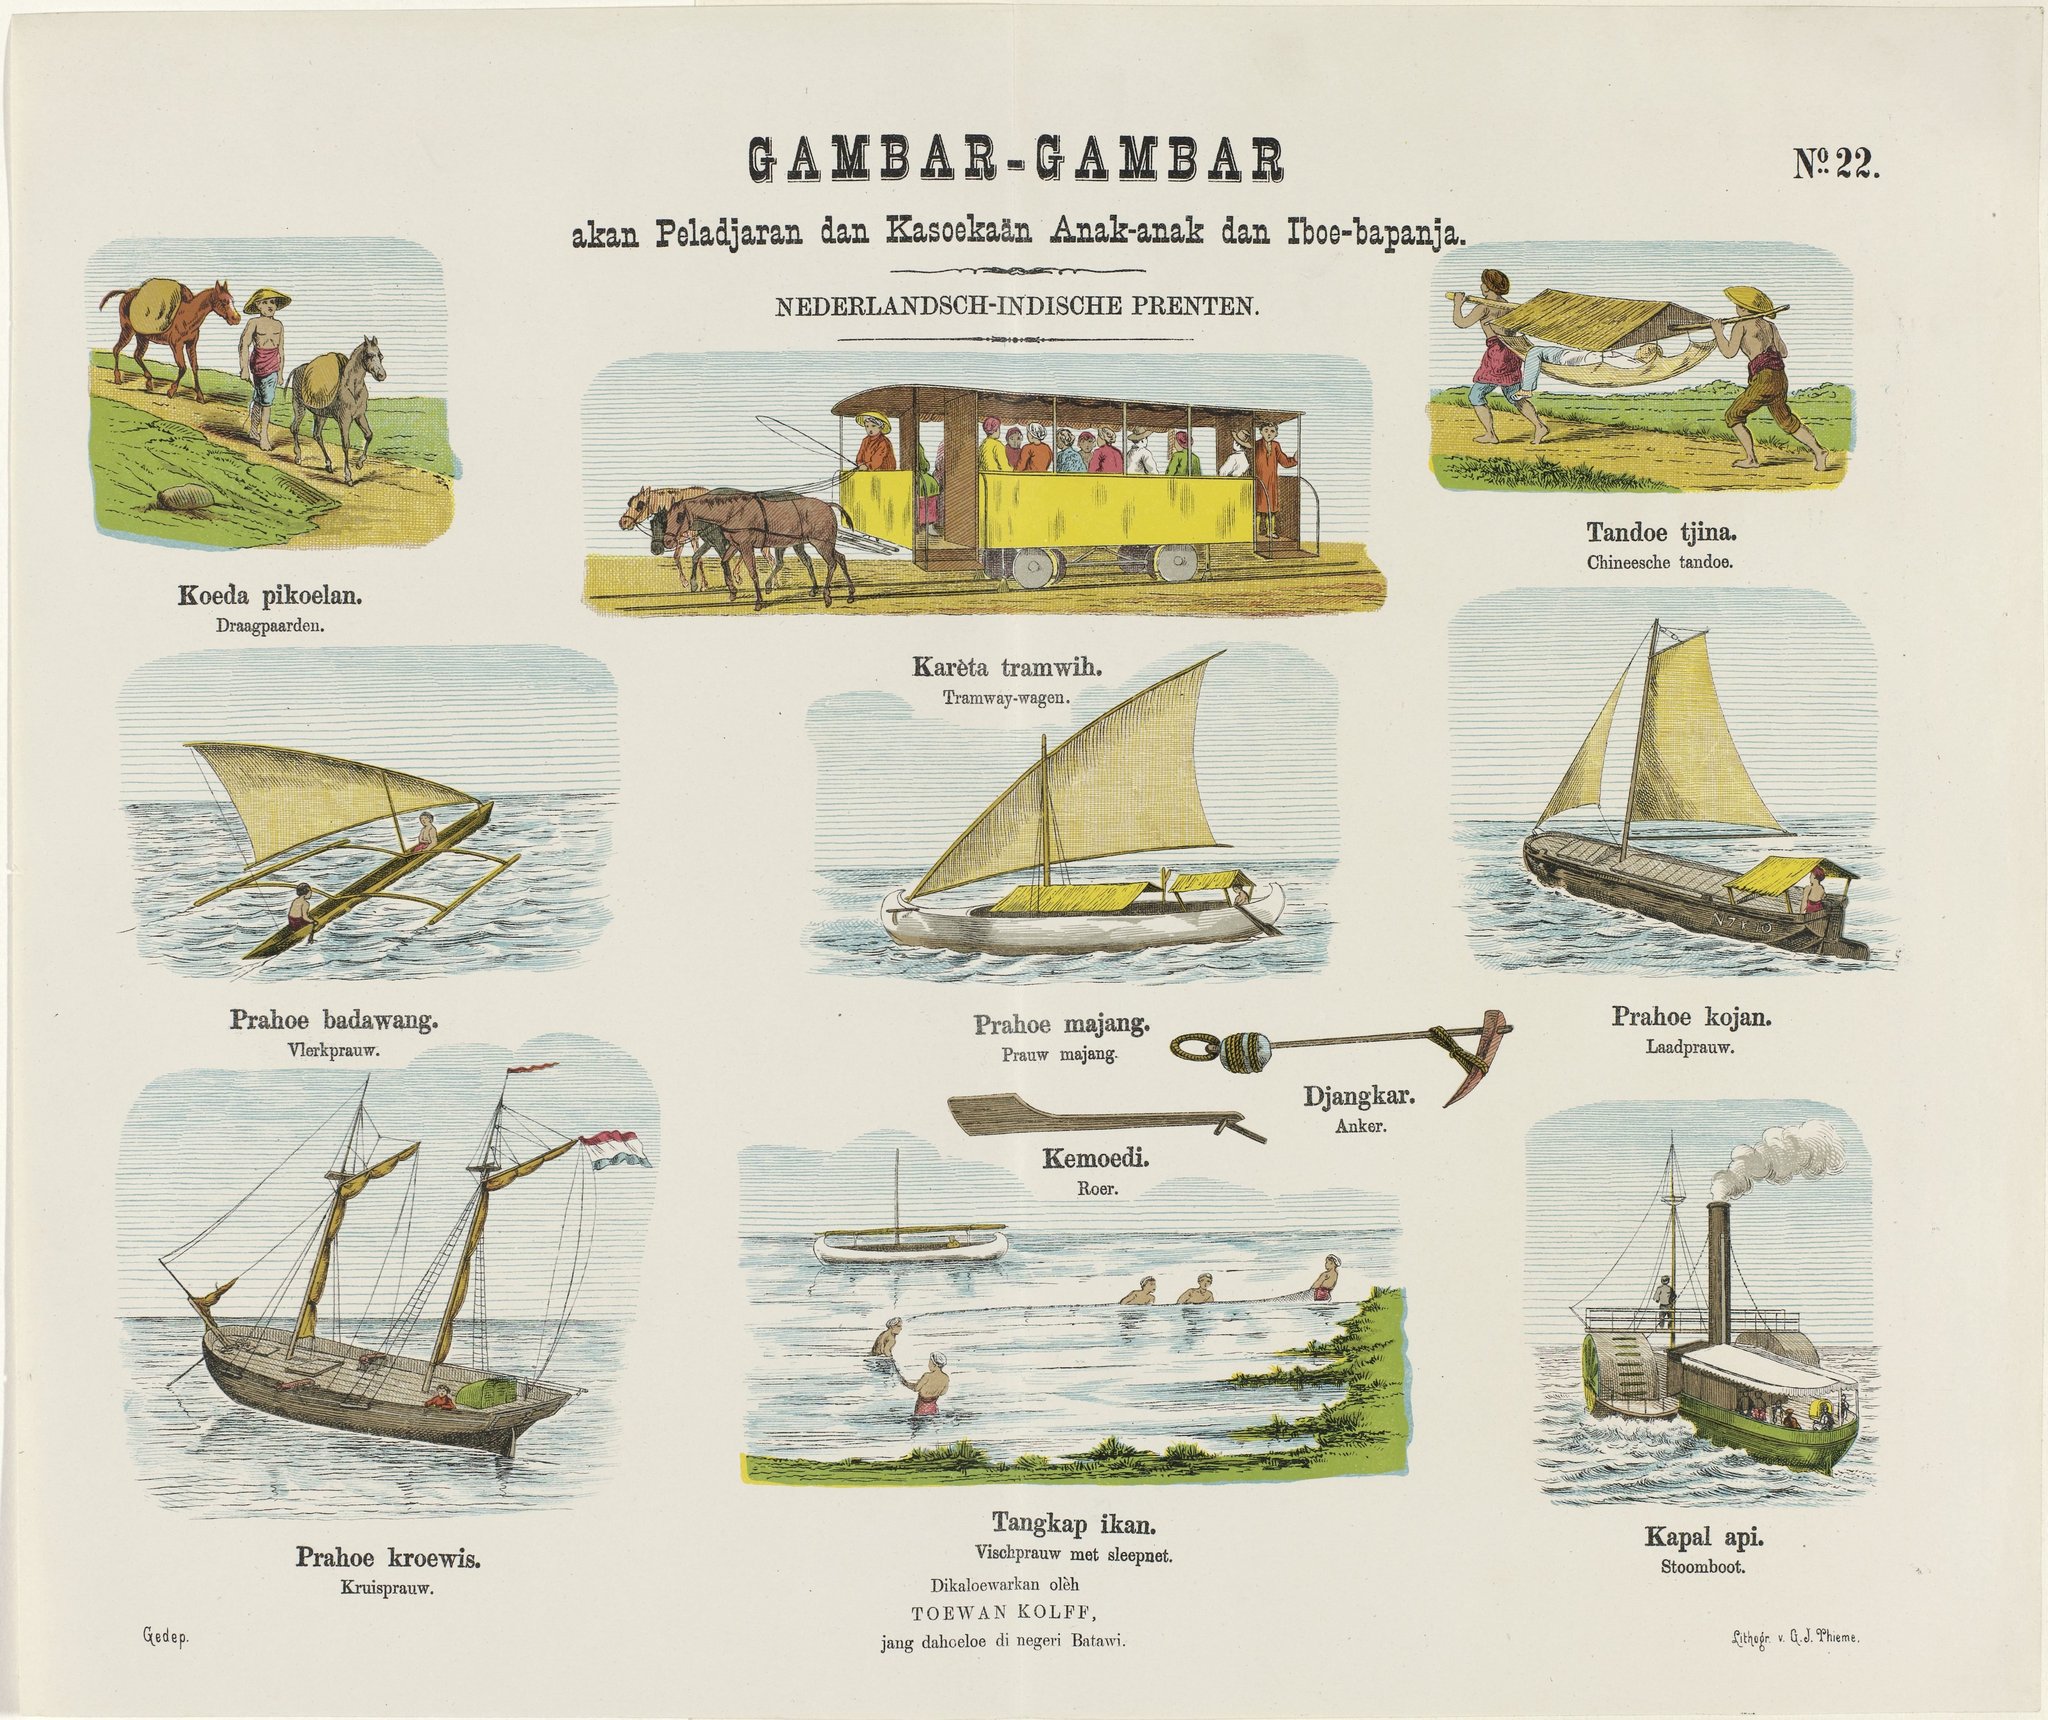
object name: popular print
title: Prenten tot nut en genoegen van jong en oud / Nederlandsch-Indische prenten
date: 1868-1881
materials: paper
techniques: lithograph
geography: netherlands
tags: asiatic races and peoples, diligence, omnibus, horse-tram, fishing net, (carrying a person in a) sedan-chair, ships (in general), dutch east indies, the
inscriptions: collector's mark: Lugt 2760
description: Blad met elf voorstellingen van vervoersmiddelen in de voormalige kolonie Nederlands-Indië, waaronder een tramwagen, een tandoe en een stoomboot. Onder elke afbeelding een onderschrift in het Maleis en het Nederlands. Genummerd rechtsboven: No. 22.